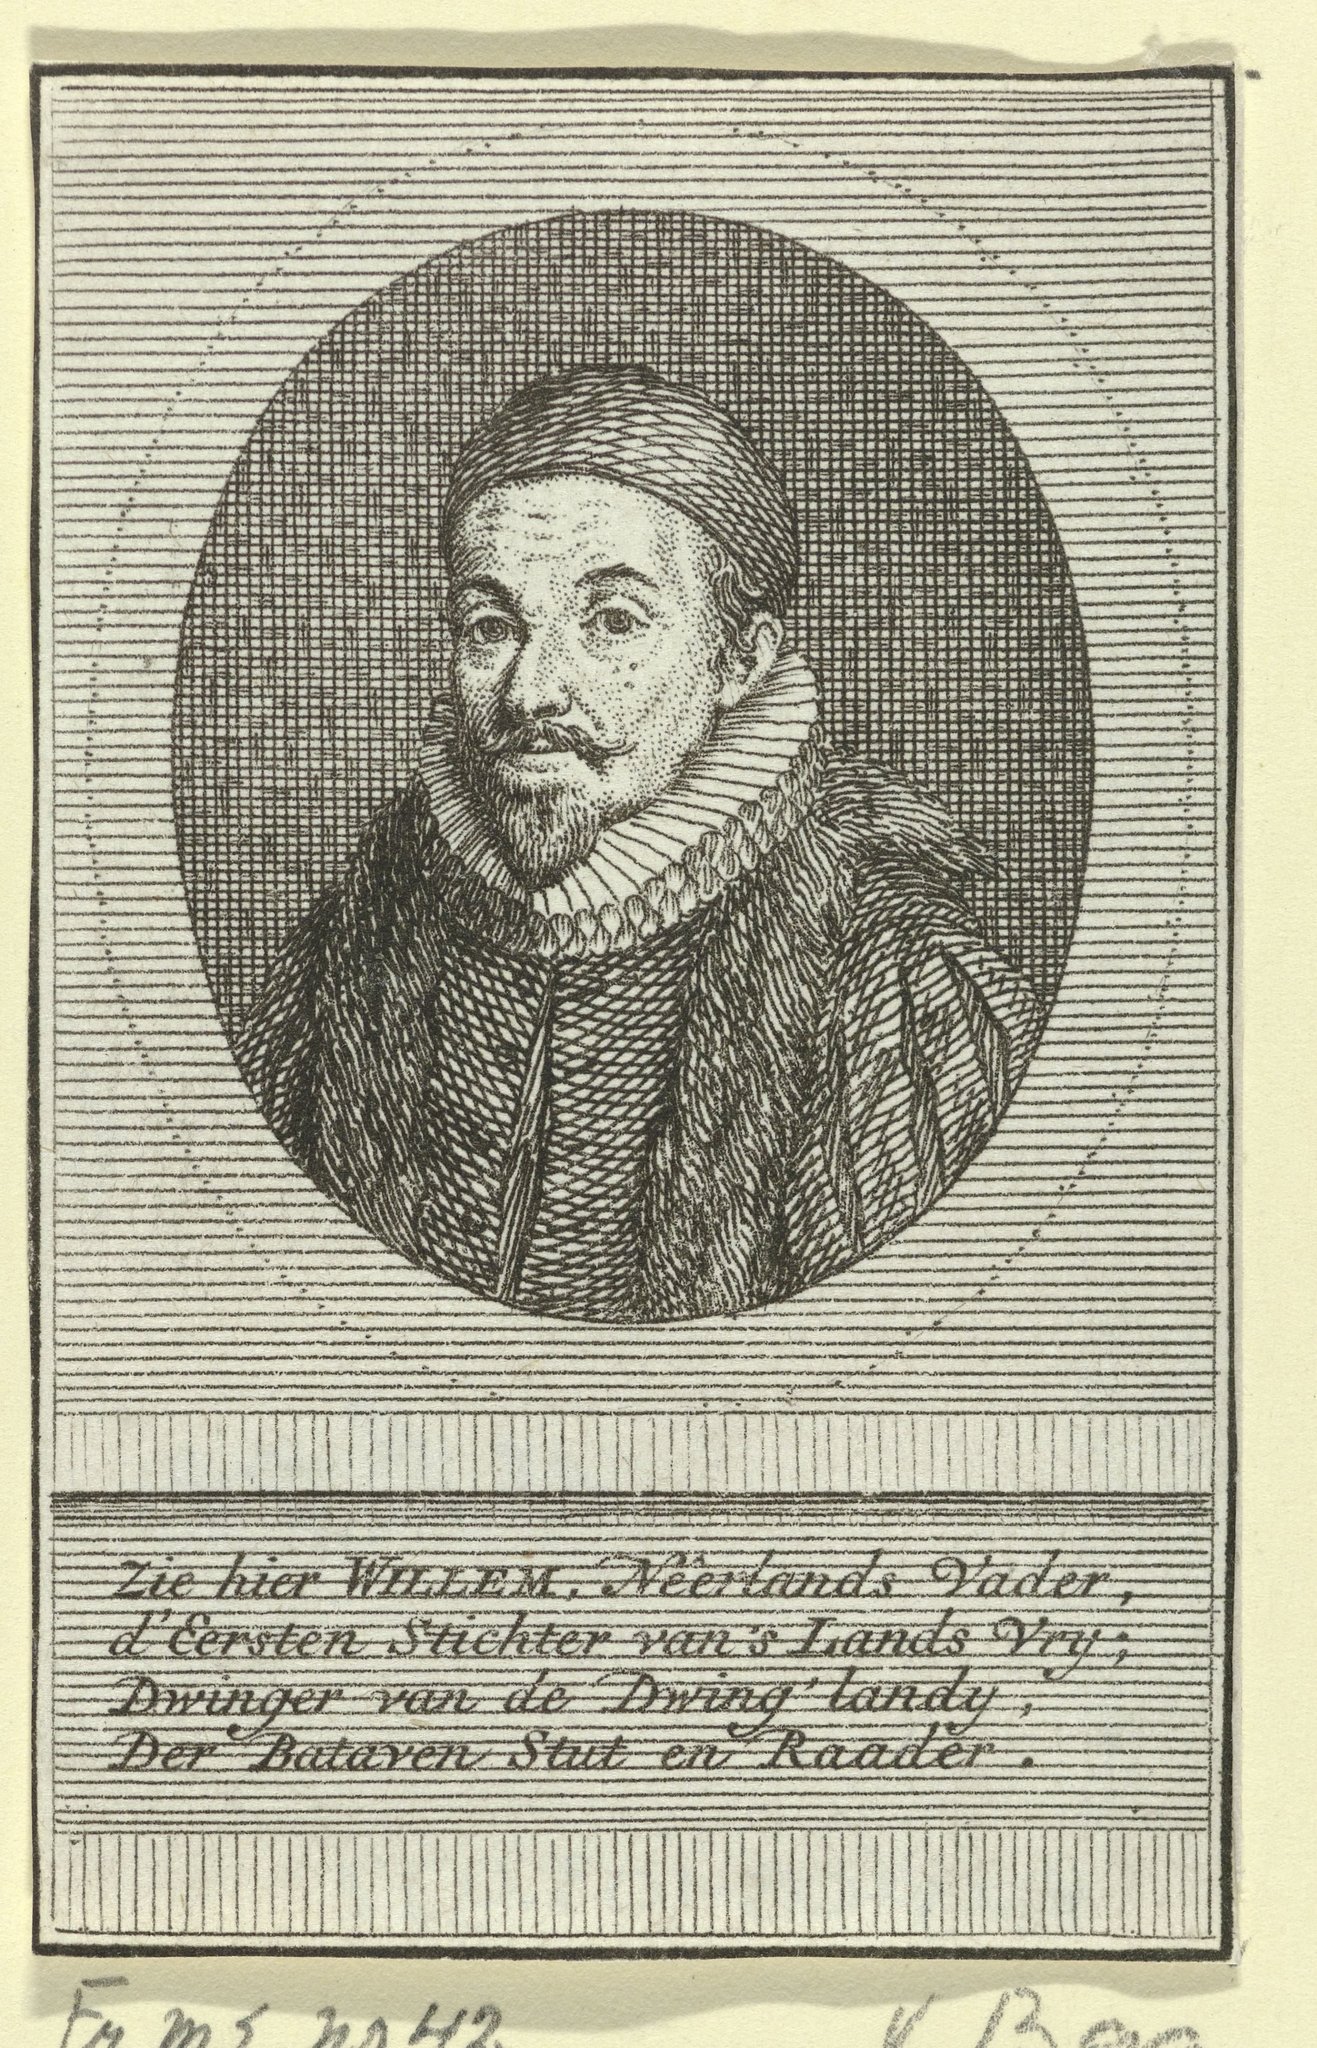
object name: print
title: Portret van Willem I, prins van Oranje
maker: Anonymous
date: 1700-1799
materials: paper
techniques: engraving, etching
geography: low countries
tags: delft, william i (prince of orange)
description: De hier vermelde titel verwijst naar de hoogst verkregen titel van de geportretteerde, niet per se naar de titel die de geportretteerde op deze voorstelling draagt.